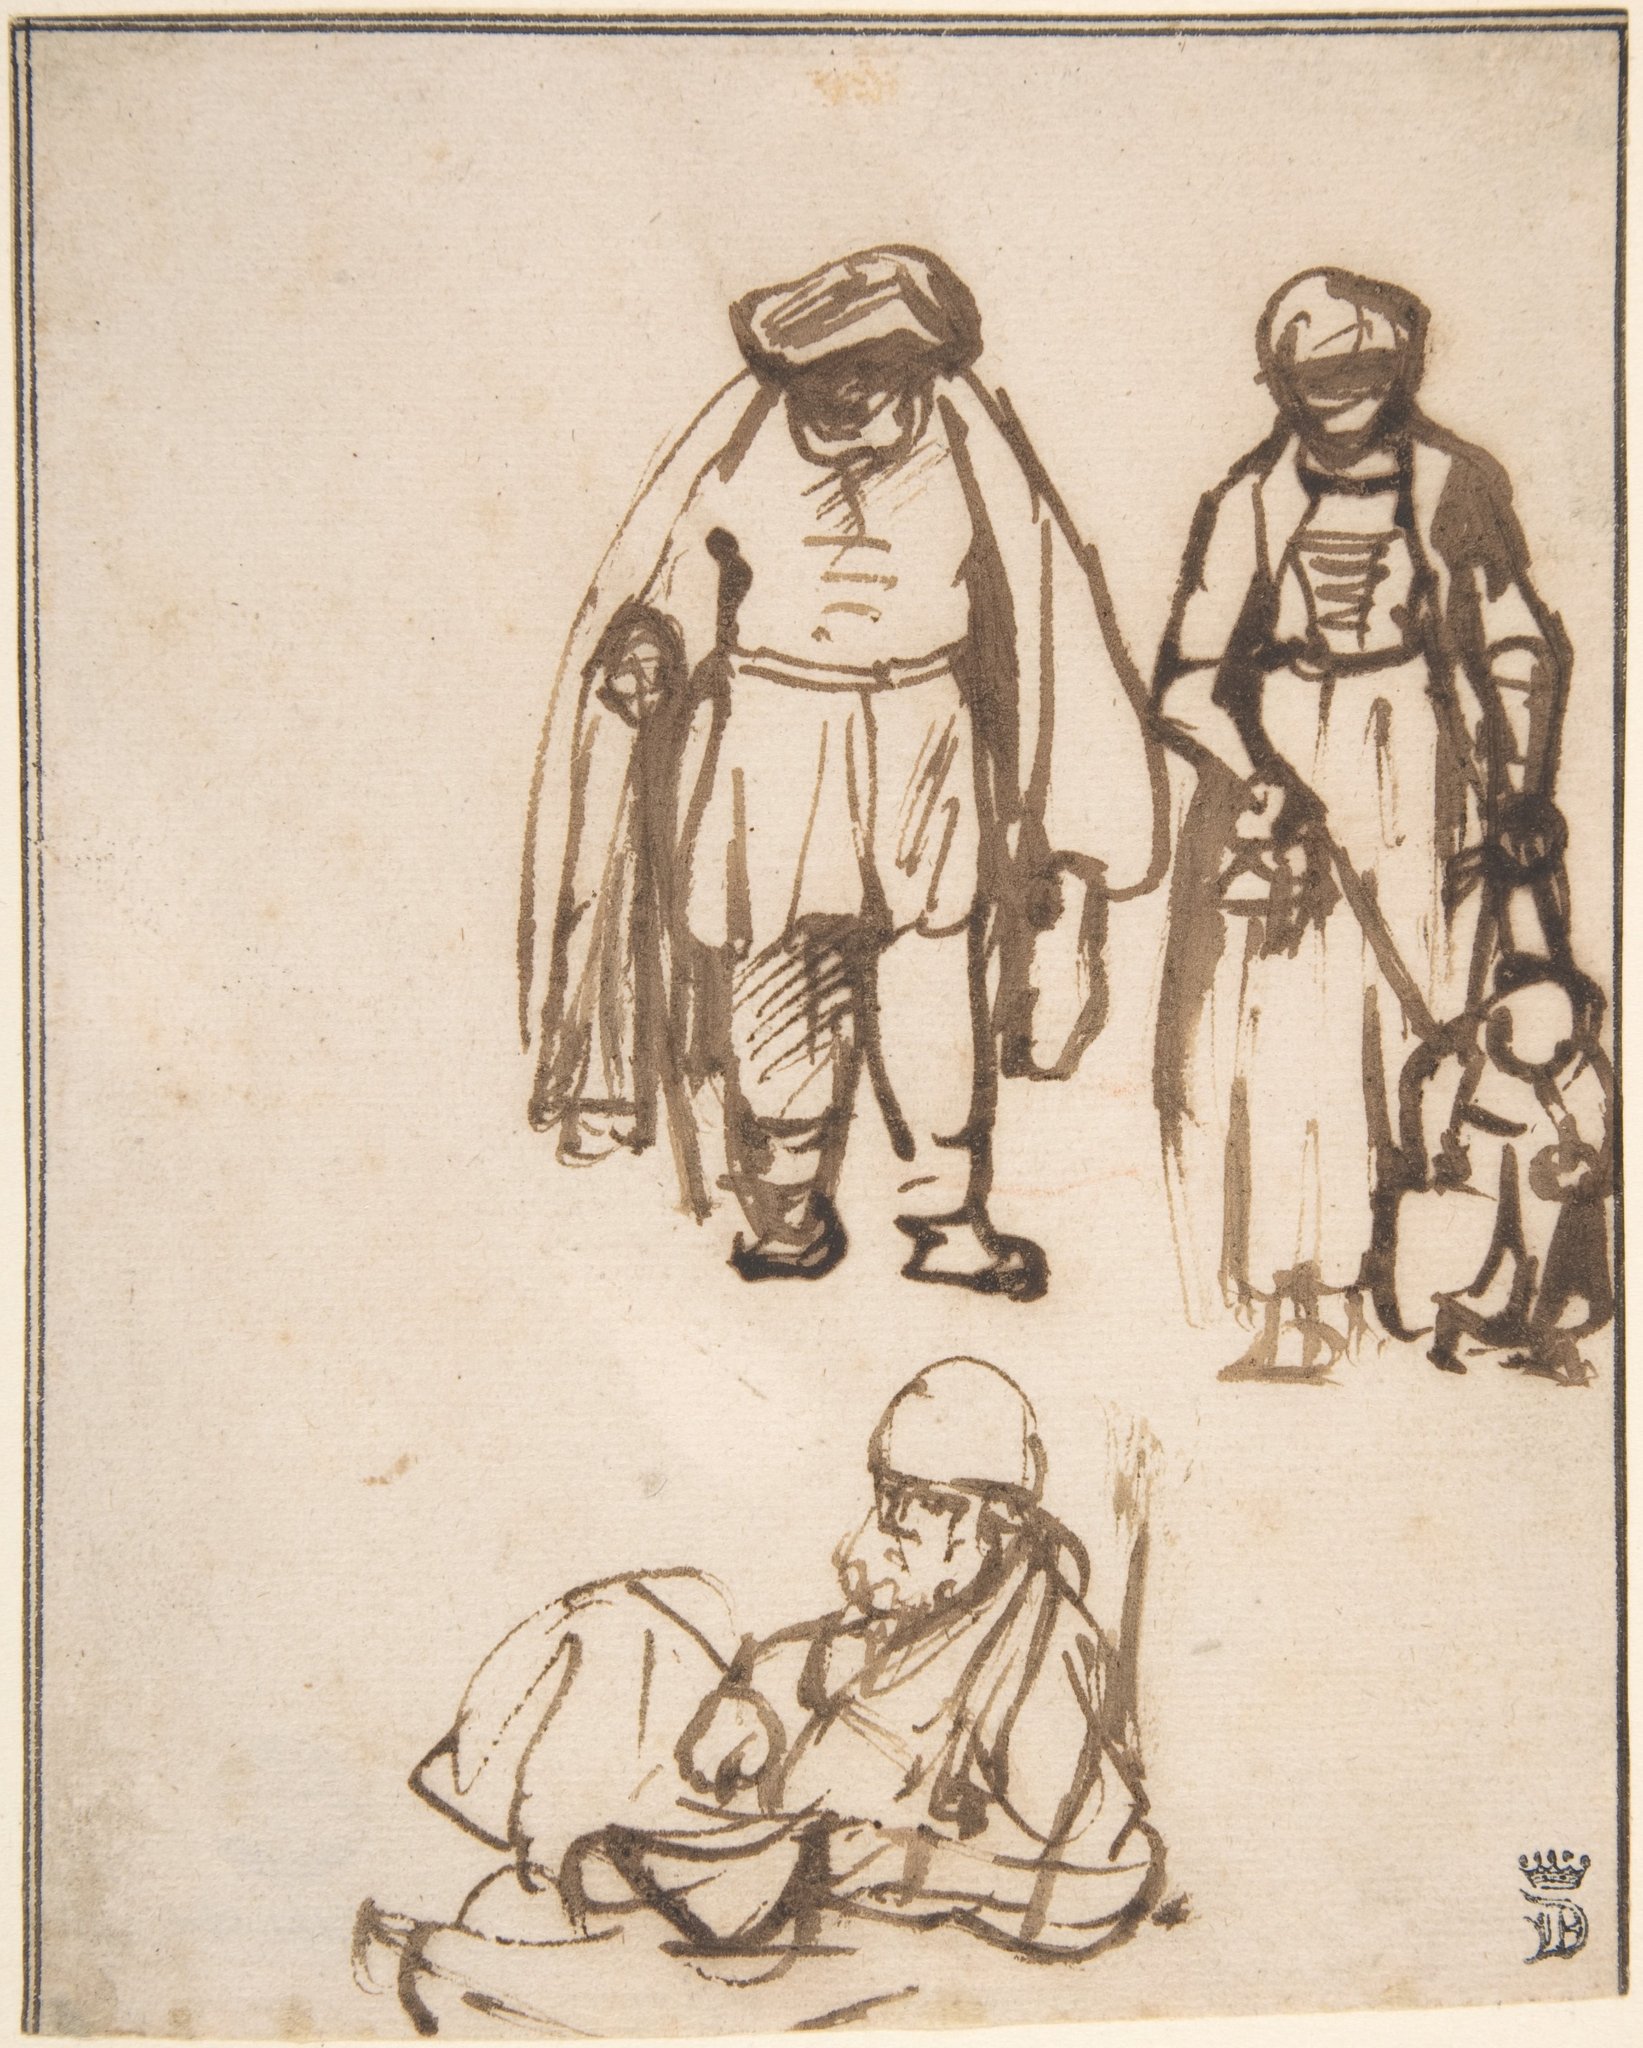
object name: drawing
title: Studies of Two Men and a Woman Teaching a Child to Walk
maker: nicolaes maes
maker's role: artist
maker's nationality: dutch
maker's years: 1634-1693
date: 1645-1650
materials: ink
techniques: pen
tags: children,men,women